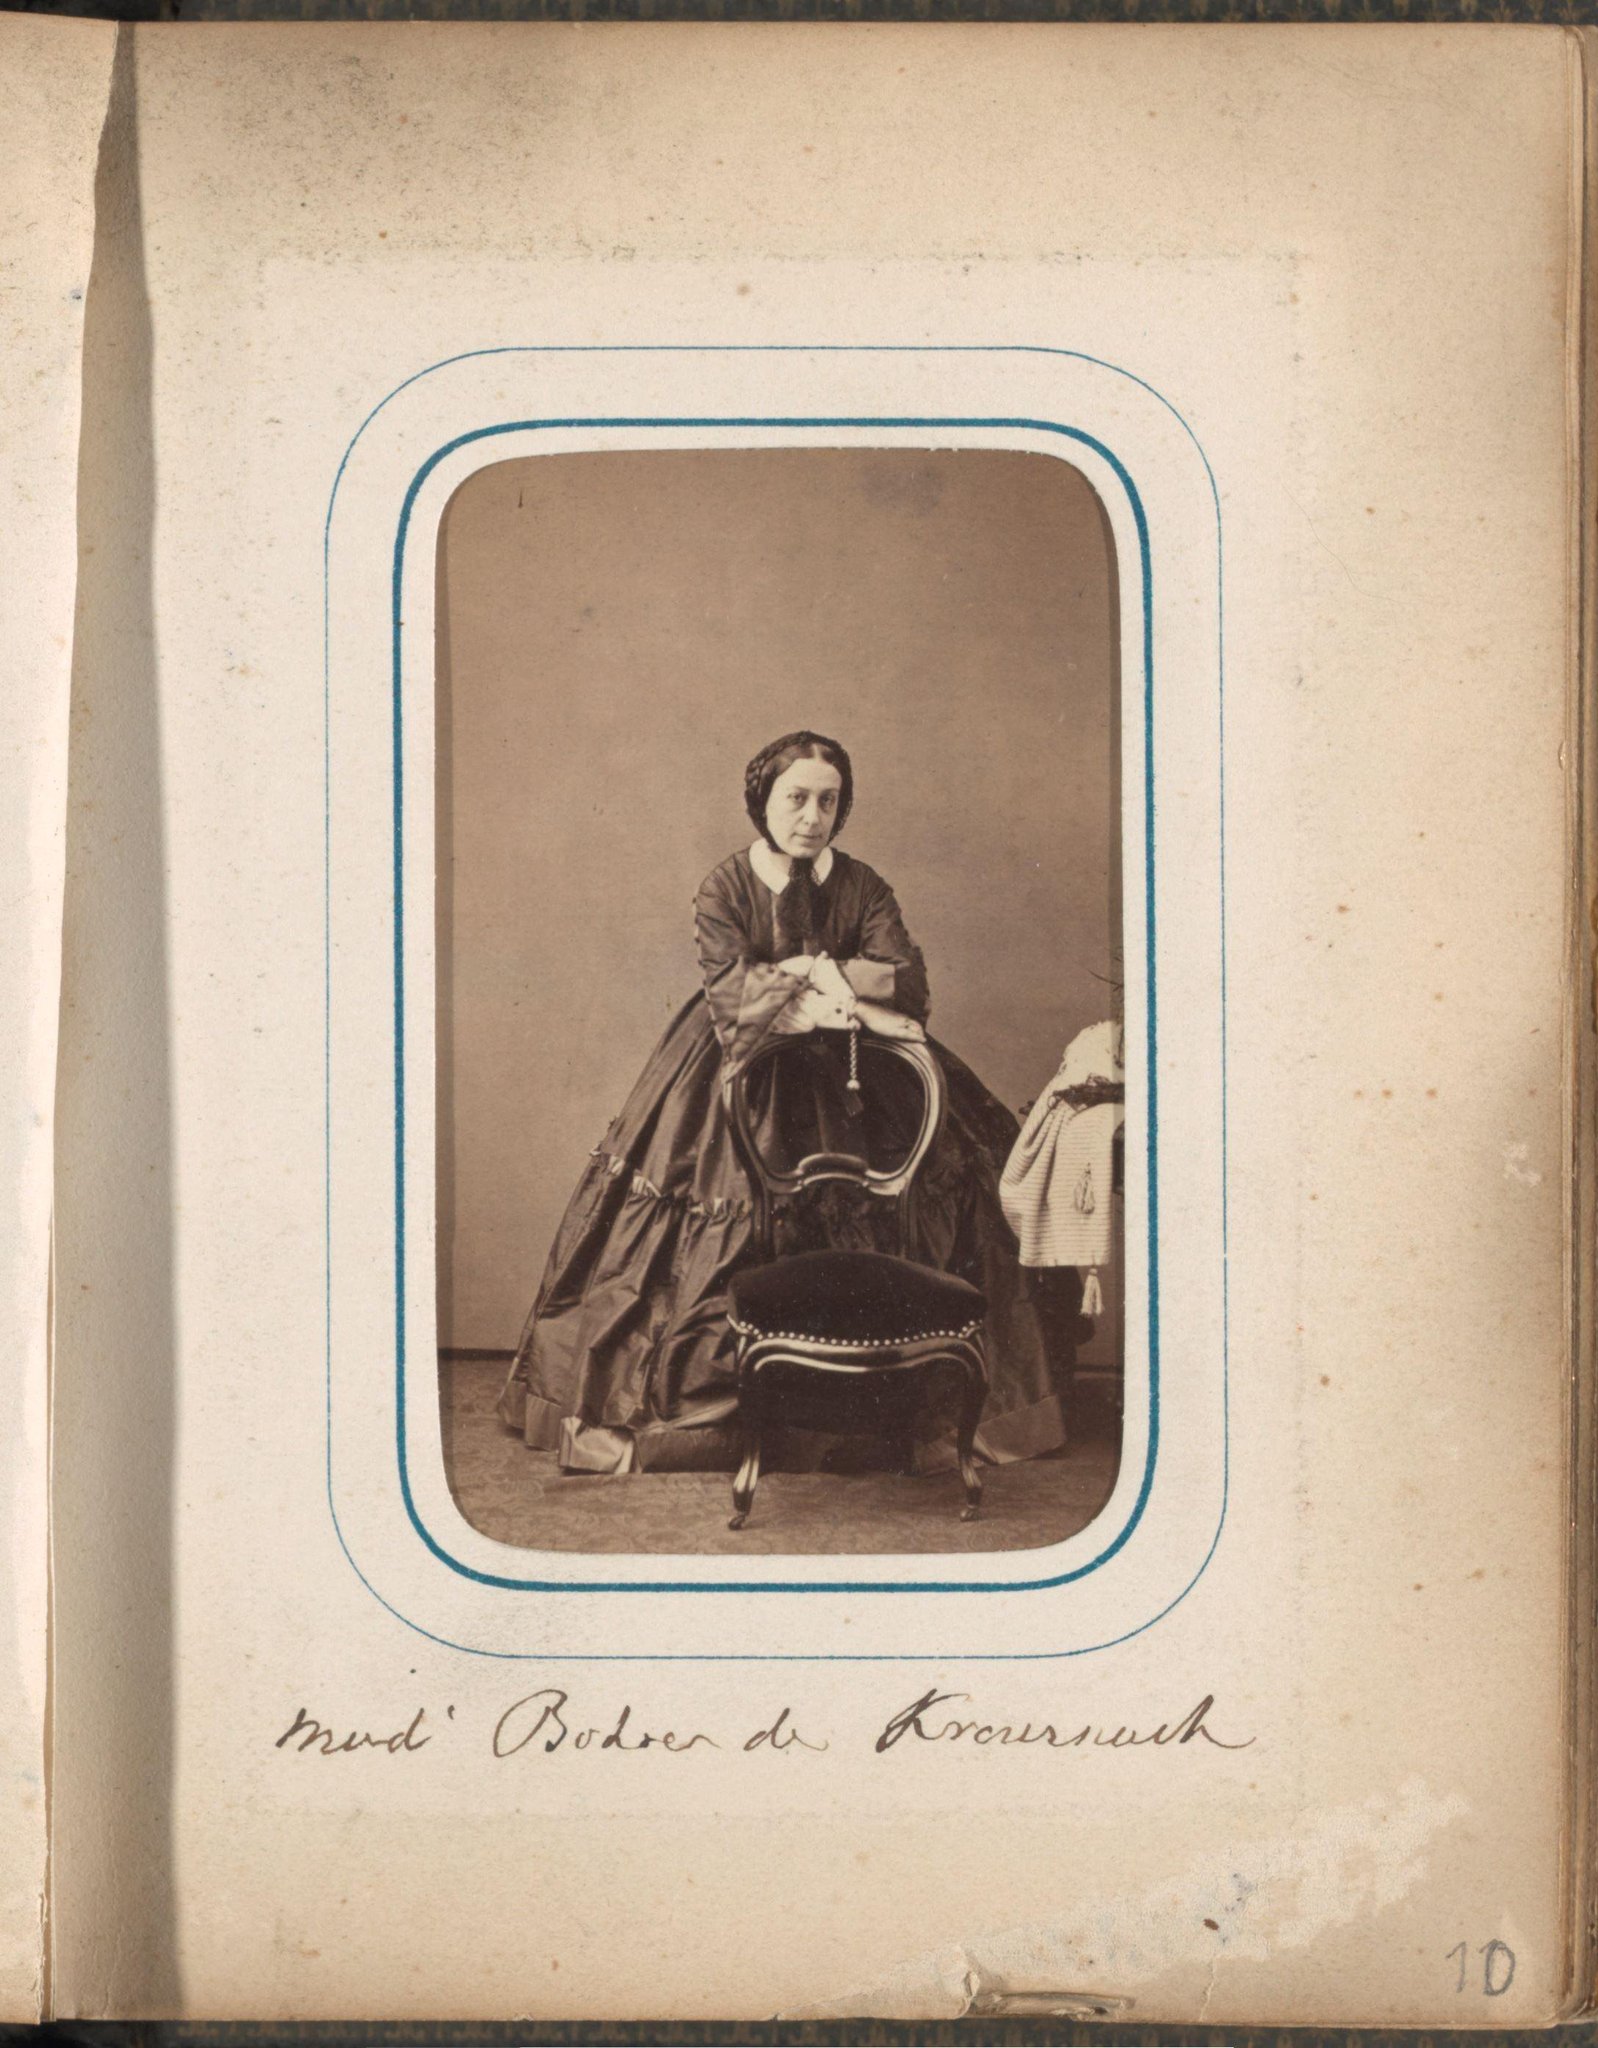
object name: carte de visite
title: Portret van een vrouw met een muts in een lange jurk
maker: Anonymous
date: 1860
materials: cardboard, paper, photographic support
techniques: albumen print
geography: lyon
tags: studio requisites ~ photographer, historical persons, styles of hairdress - aa - ~ women, bracelet, wristlet, head-gear: cap, dress, gown, lyon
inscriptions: date: ‘le 28 Septembre 1860’, address: ‘Lyon’, name: ‘Mad. [...] de Kreuznach’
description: Onderdeel van Fotoalbum met 24 cartes-de-visite van Franse personen.